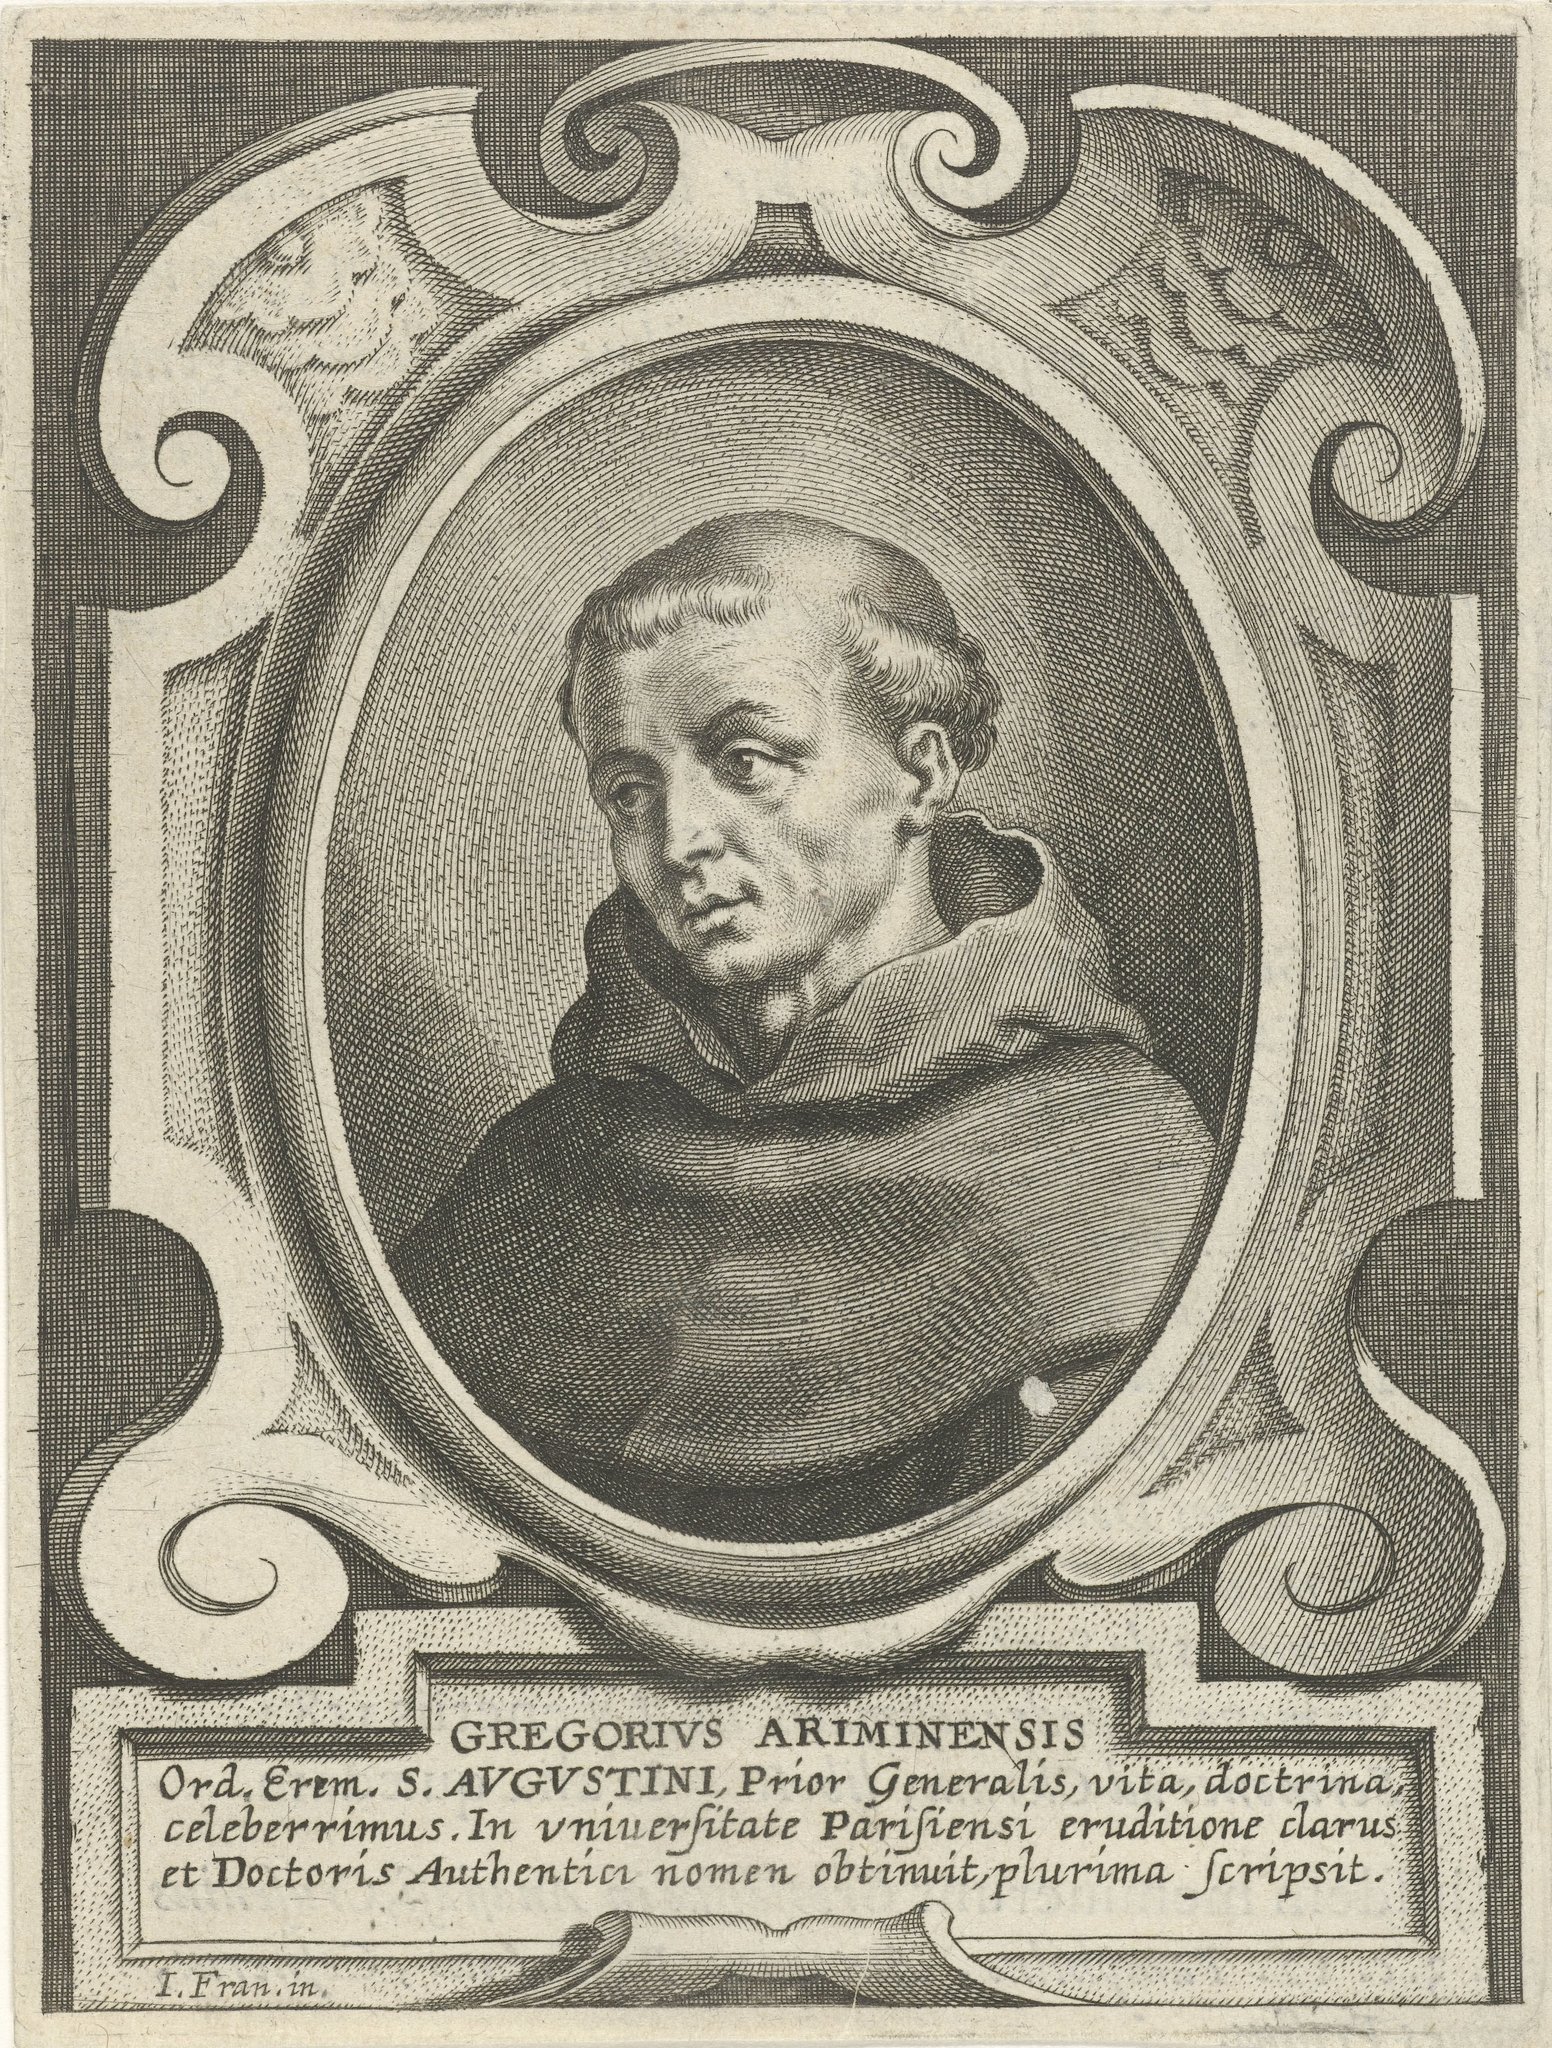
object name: book illustration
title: Portret van de Augustijn Gregorius Ariminensis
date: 1636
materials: paper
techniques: engraving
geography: southern netherlands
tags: monastic orders, monastic life ~ roman catholic church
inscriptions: collector's mark: Lugt 2228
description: Boekillustratie voor: C. Curtius, Virorum illustrium ex ordine Eremitarum D. Augustini elogia , Antwerpen: J. Cnobbaert, 1636.